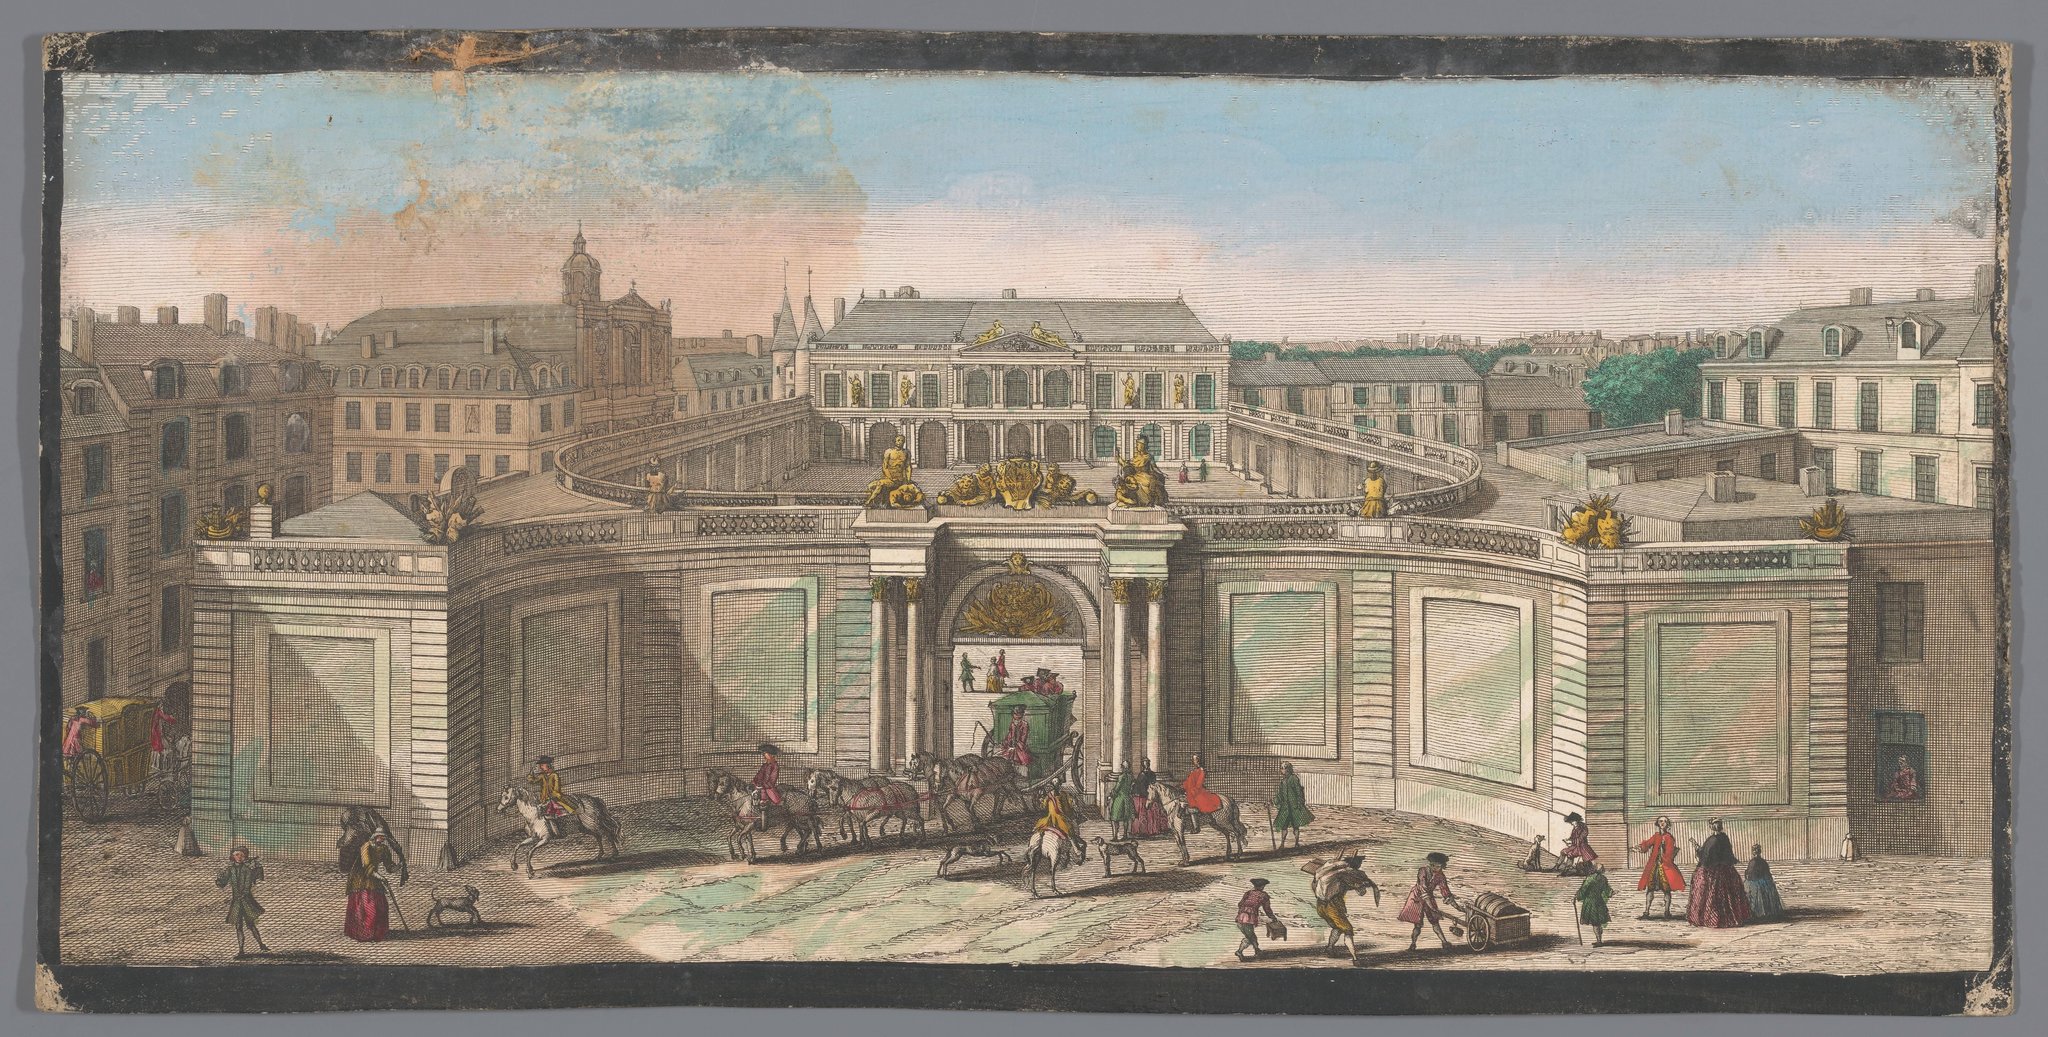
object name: opticaprent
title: Gezicht op Hôtel de Soubise te Parijs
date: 1700-1799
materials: cardboard, paper, watercolor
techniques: brush, etching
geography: paris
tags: palace